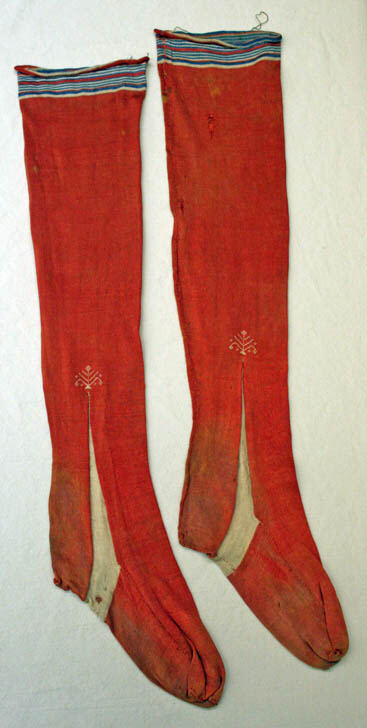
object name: stocking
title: Stockings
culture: european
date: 1801-1900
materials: silk